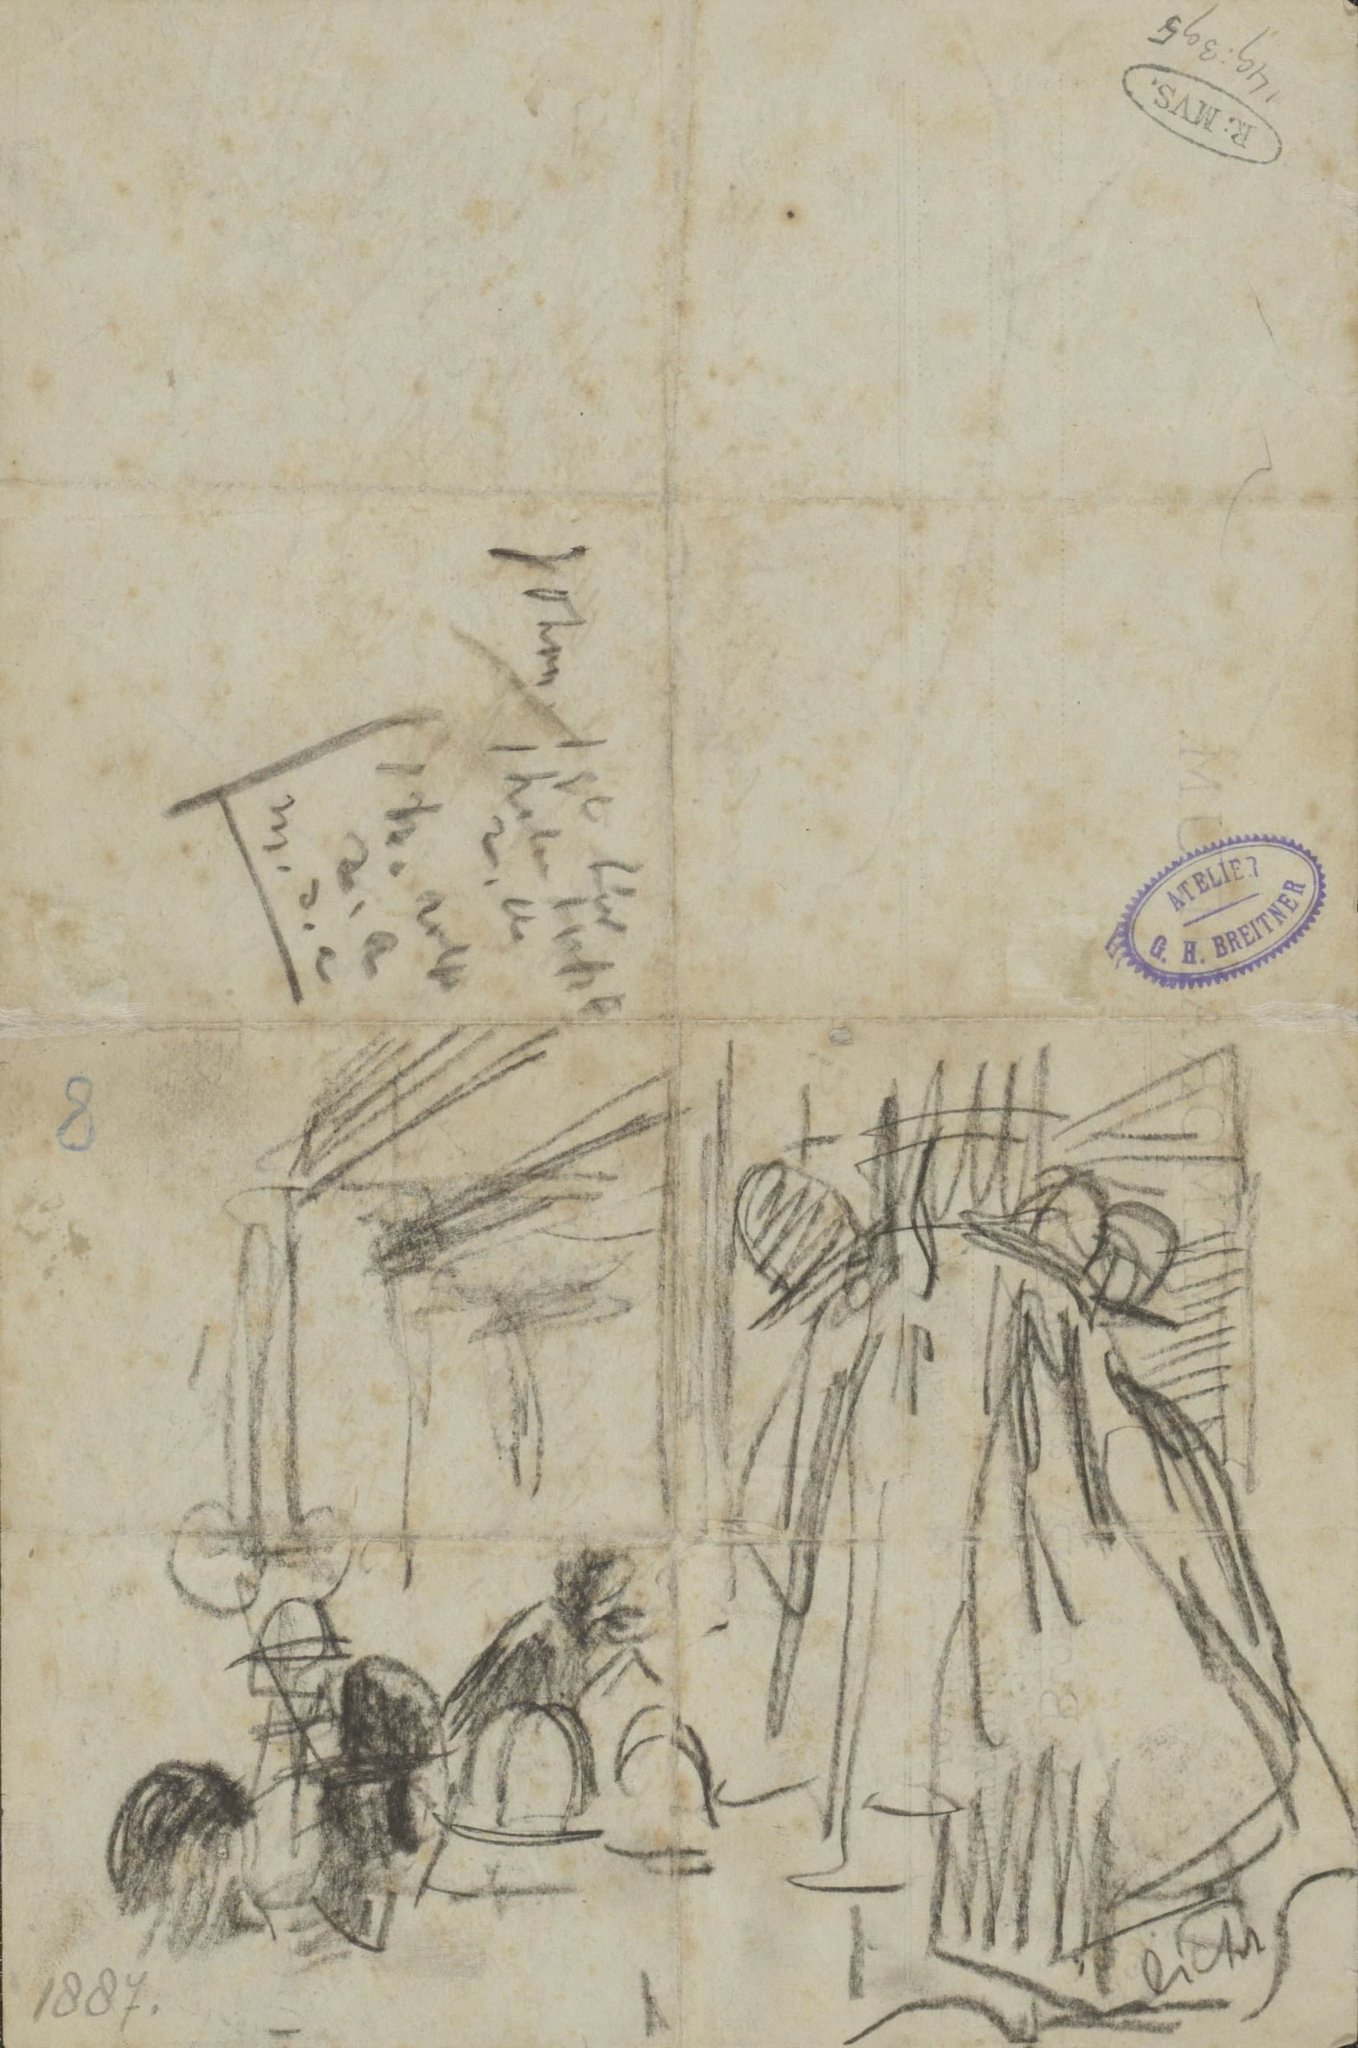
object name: drawing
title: Kapstok in een café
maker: george hendrik breitner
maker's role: draughtsman, painter, print maker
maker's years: 1857-1923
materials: chalk, paper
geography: amsterdam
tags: inn, coffee-house, public house, etc.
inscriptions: collector's mark: Lugt 2228, workshop stamp: Lugt 291d, annotation: ‘Memorandum./ Van Bloemendal & Kerkhoven./ Rotterdam, 21 Sept. 1887./ London, 23 Charterhousestreet E.C./ Amice/ Ik ben met je apologie nog niet/ heelemaal tevreden. Ik neem het je niet/ kwalijk dat je mij, als zijnde degeen die het/ heeft, vraagt om hetgeen jou mankeert,/ maar wel dat ik in zoo langen tijd niets/ anders van je hoorde; in je laatste [...]/ ik ben al begonnen nog wat meer/ te schrijven, en hou me verder aanbevolen./ Saluut/ [...]’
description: In de buurt van de kapstok zitten figuren. Verso een brief aan Breitner.